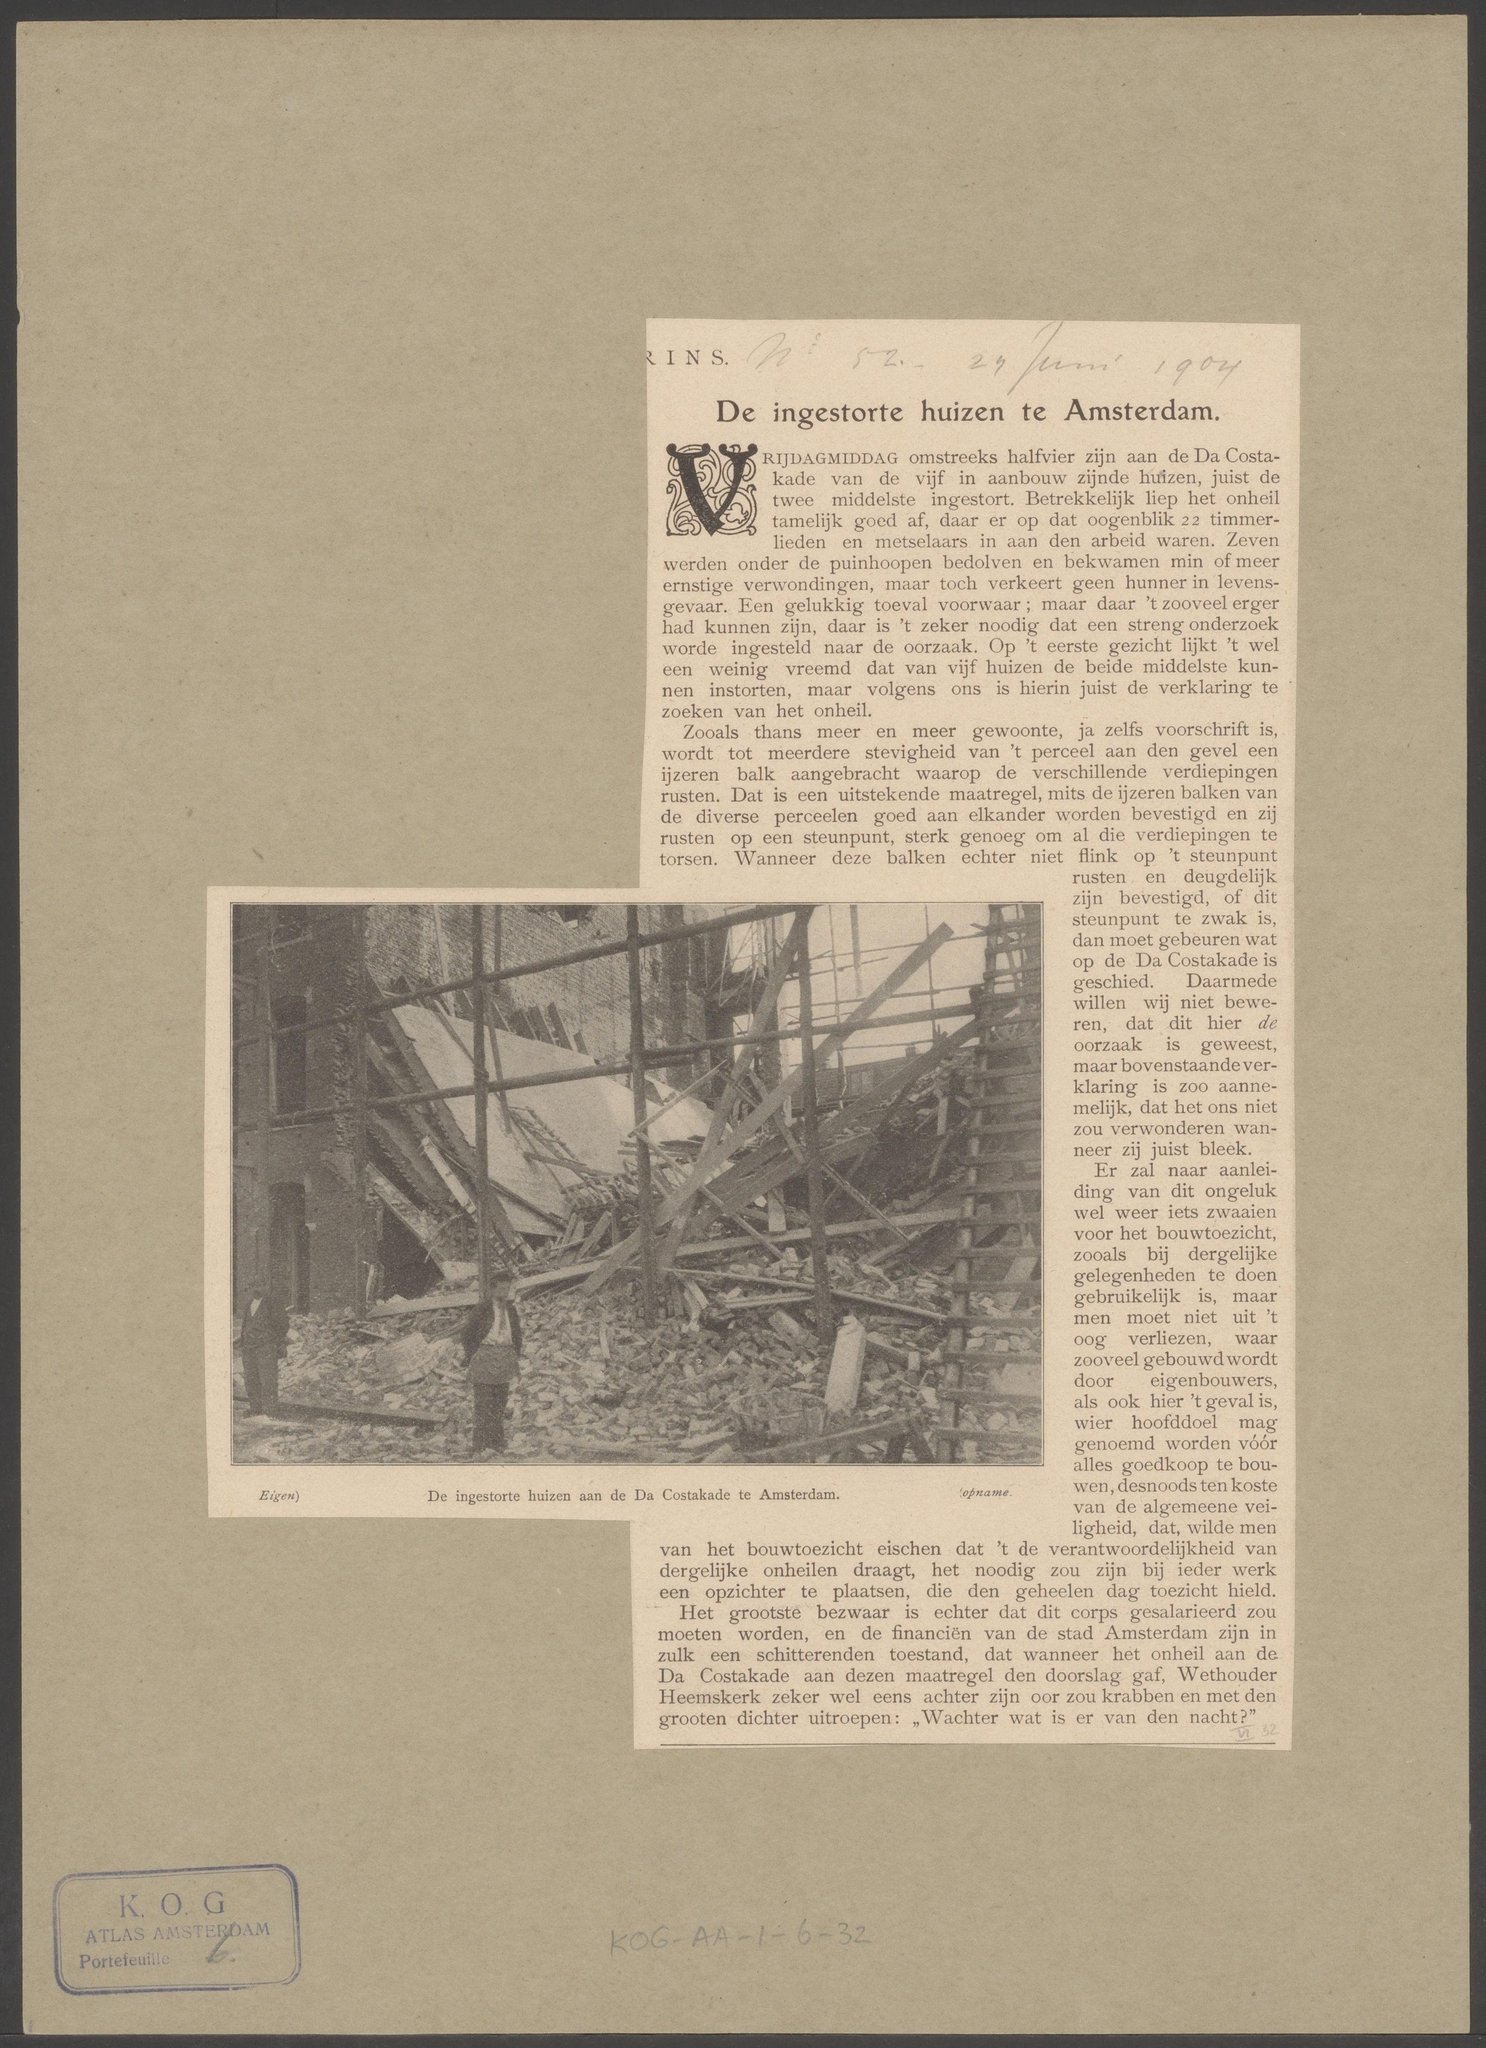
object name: photomechanical print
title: Gezicht op twee ingestorte huizen aan de Da Costakade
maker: Anonymous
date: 1904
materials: paper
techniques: letterpress printing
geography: amsterdam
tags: city-view in general; 'veduta', collapsing building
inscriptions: collector's mark: ‘6’ Lugt 1641b, inscription: ‘n: 52.- 27 juni 1904’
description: Onderwerpsrubriek binnen de Atlas Amsterdam: Buijskade, Catskade (Jacob), Clercqstraat (de), Commelinstraat, Costakade (da), Cuypstraat (Albert), Czaar Peterstraat.